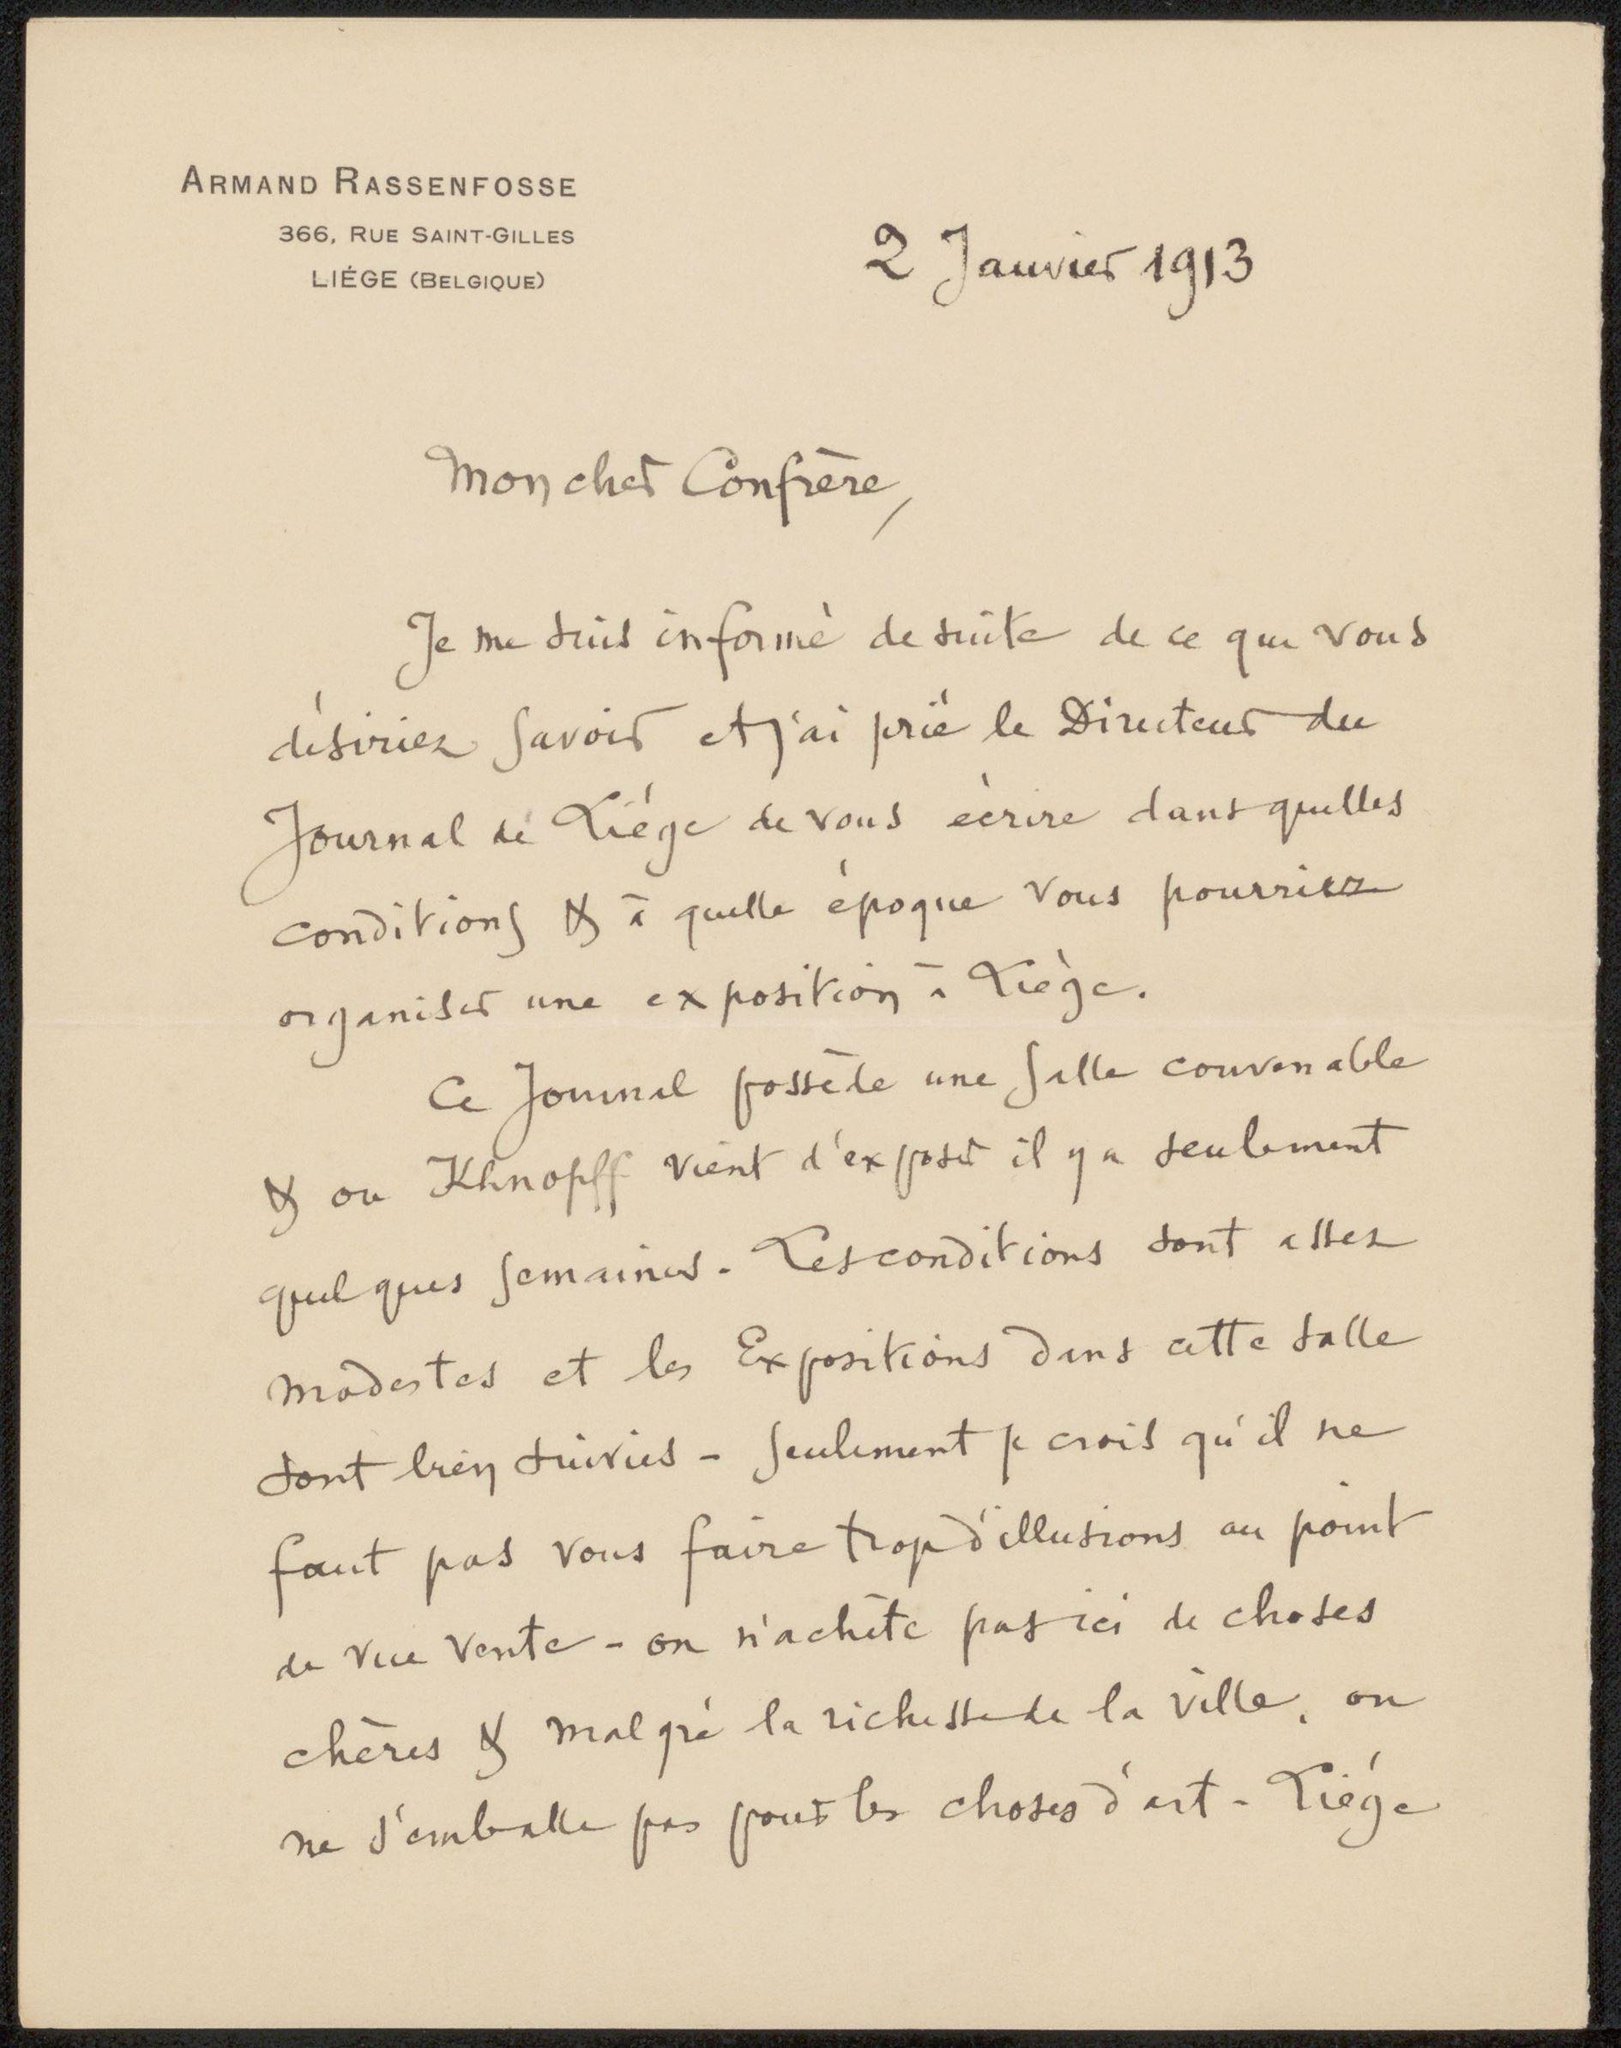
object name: letter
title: Brief aan Philip Zilcken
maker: armand rassenfosse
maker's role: draughtsman, painter, print maker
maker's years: 1862-1934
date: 1913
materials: ink, paper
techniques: pen, printing, writing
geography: liège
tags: fernand khnopff, philip zilcken, exhibition ~ art, liège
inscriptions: collector's mark: ‘RPK’